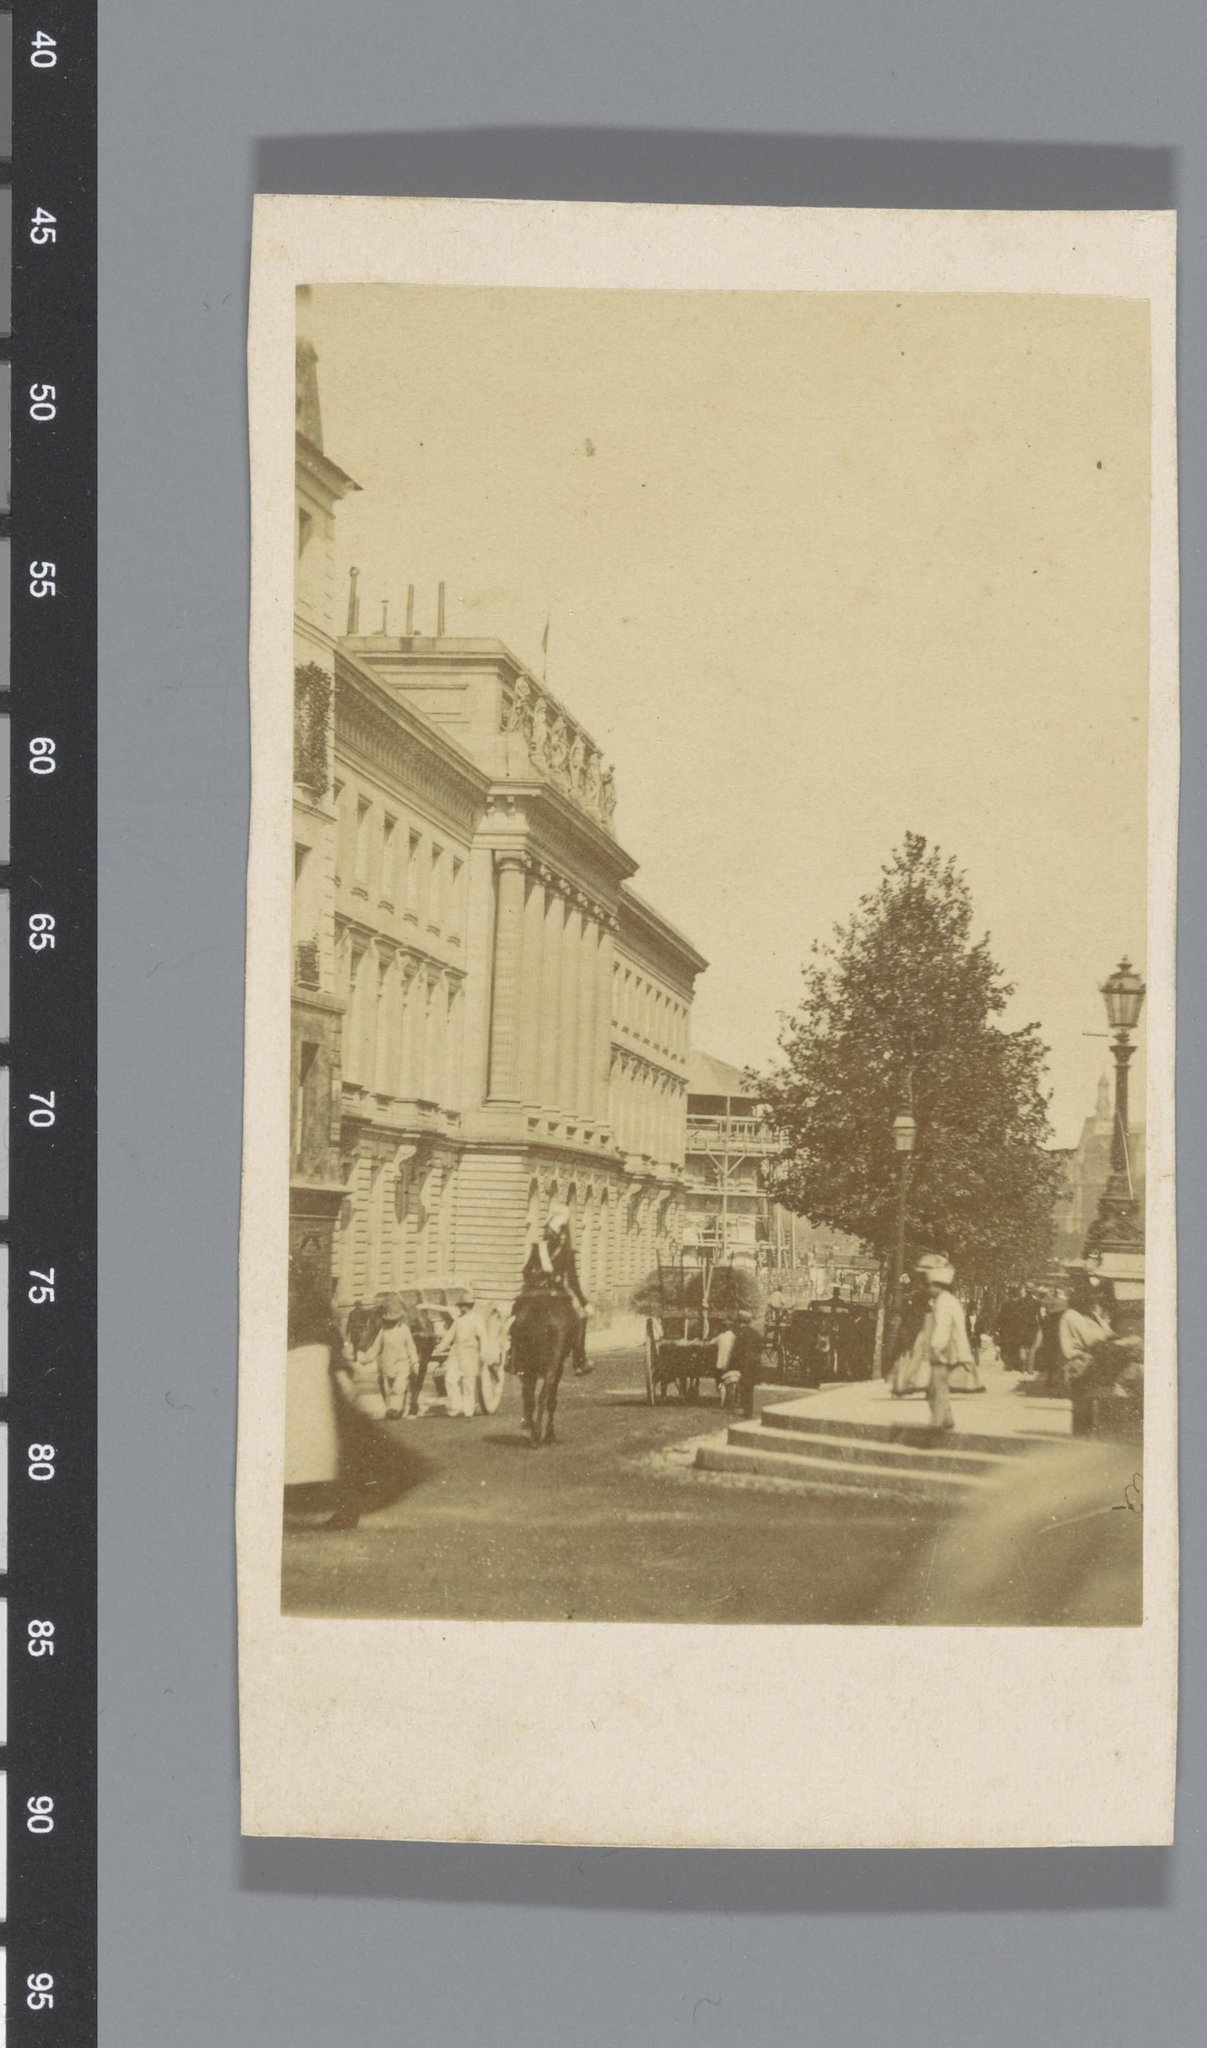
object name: photograph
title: Hôtel de la Monnaie, Parijs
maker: Anonymous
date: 1865-1870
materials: cardboard, paper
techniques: albumen print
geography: paris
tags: street (+ city(-scape) with figures, staffage), paris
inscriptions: inscription: ‘Hotel de la Monnaie/ Pris’